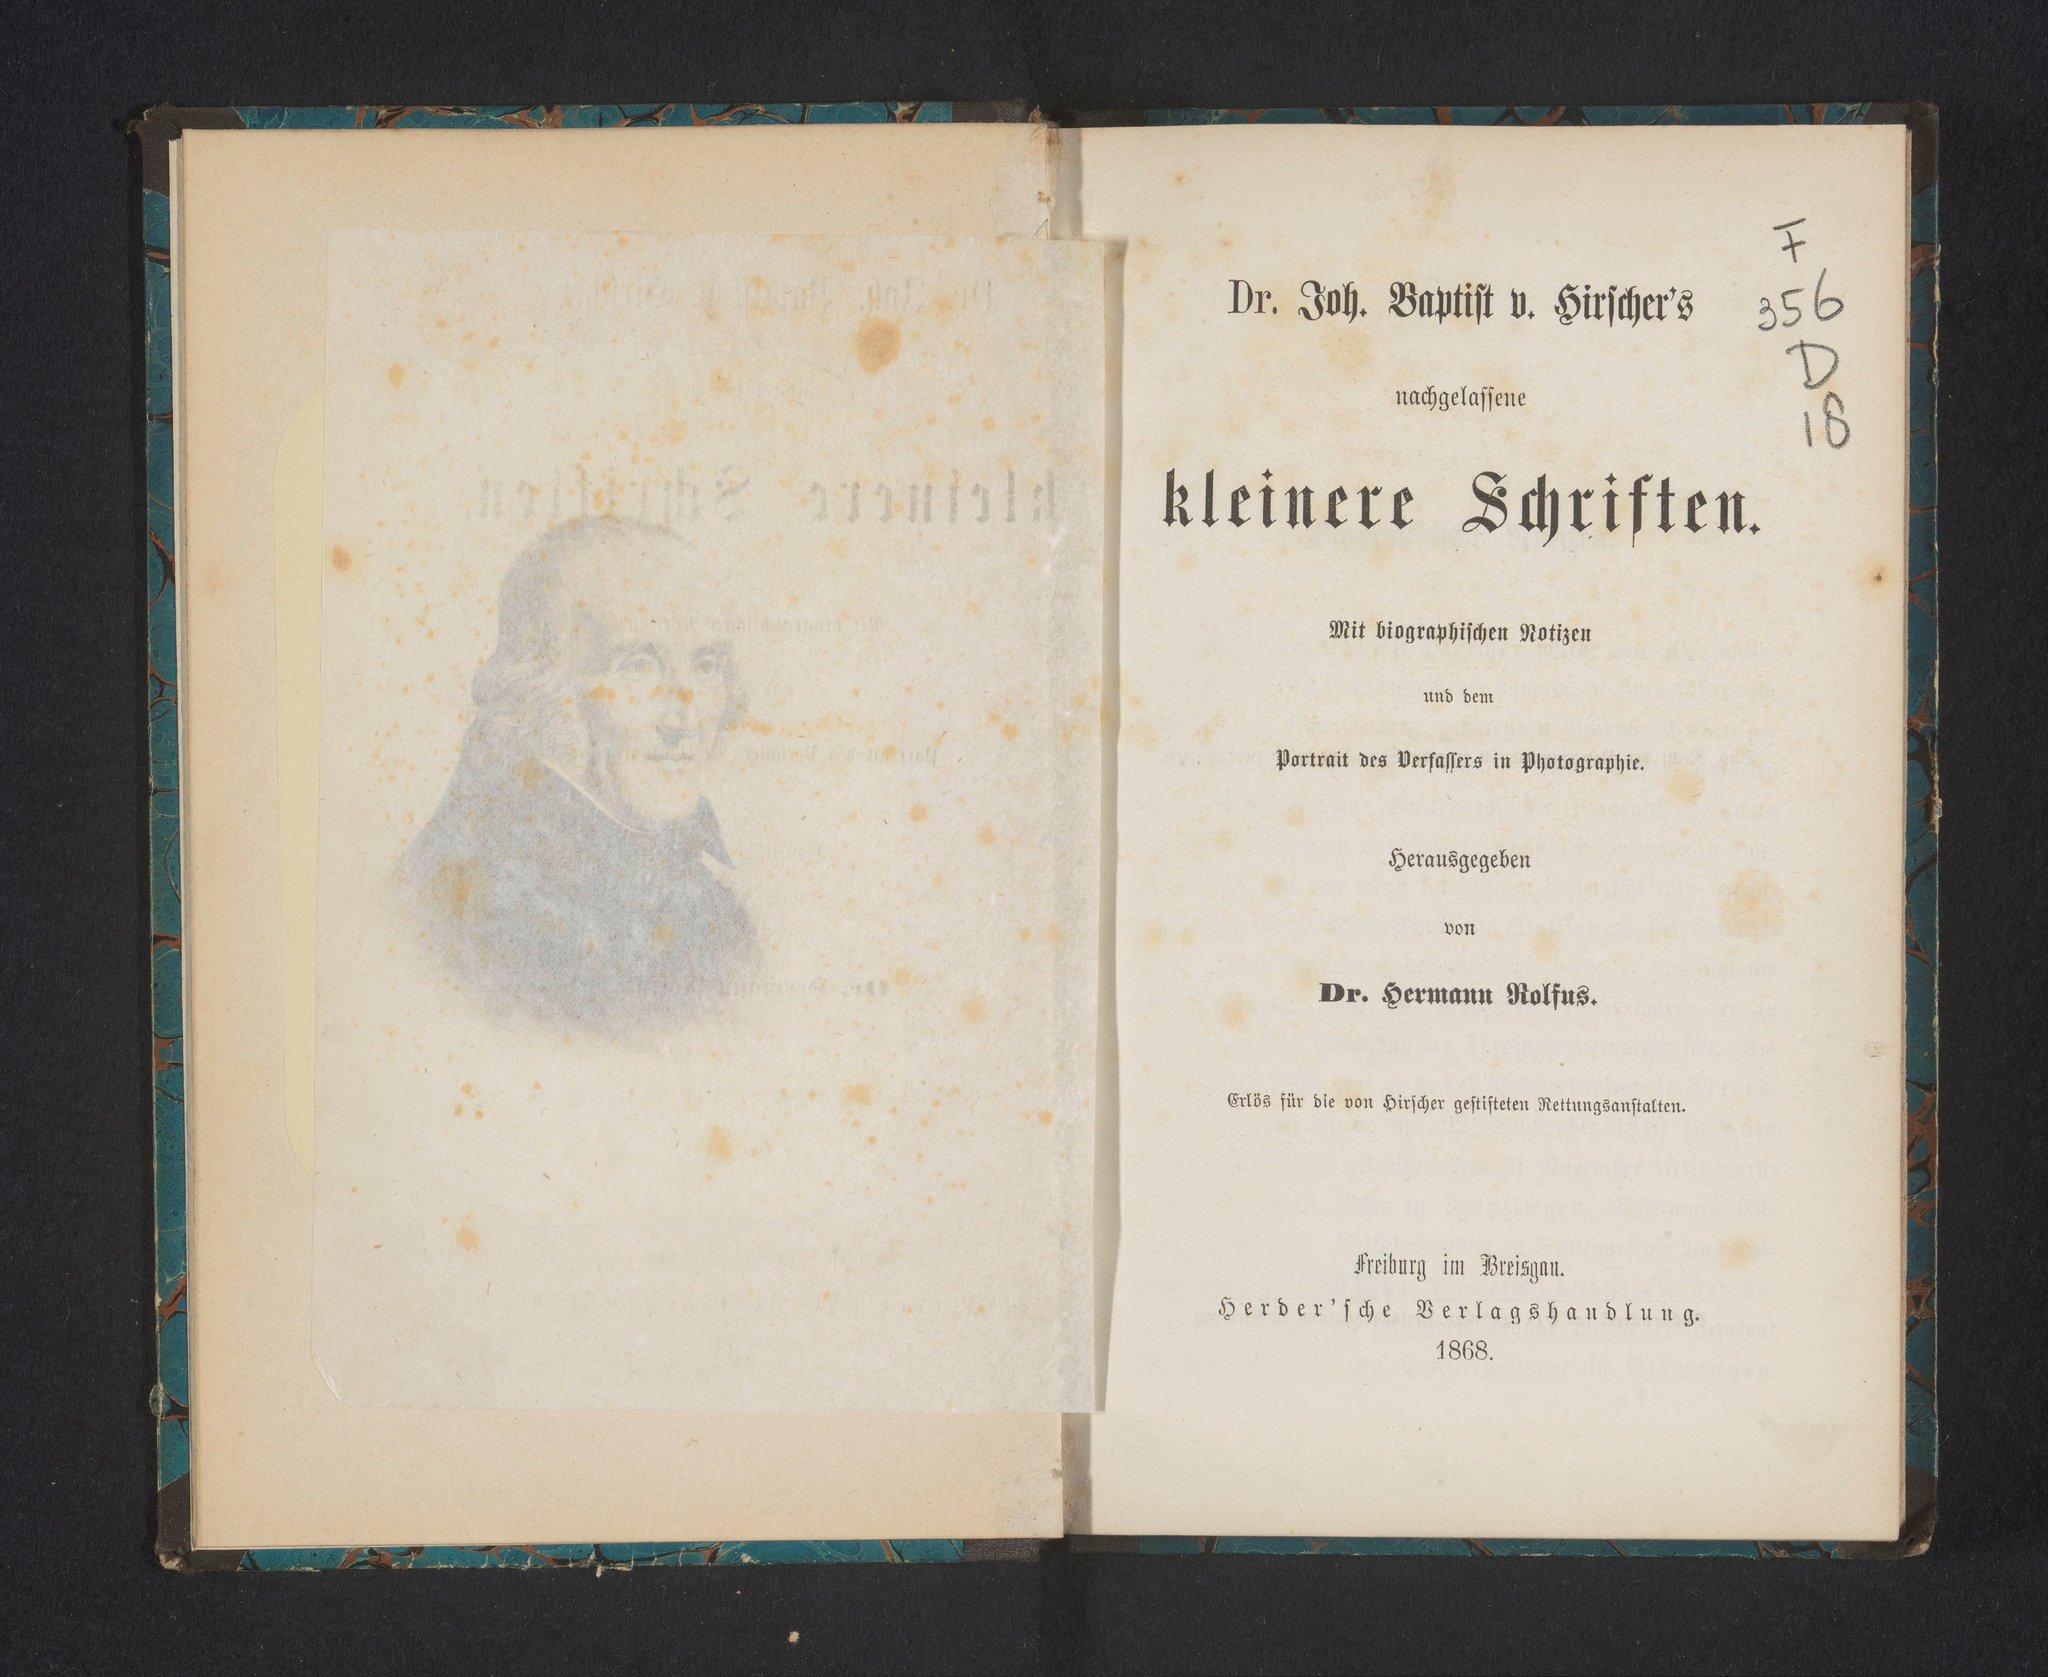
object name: book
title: Dr. John Baptist v. Kirscher's nachgelassene kleinere Schriften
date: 1868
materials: cardboard, linen, paper, photographic support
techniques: albumen print, printing, marbling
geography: freiburg im breisgau